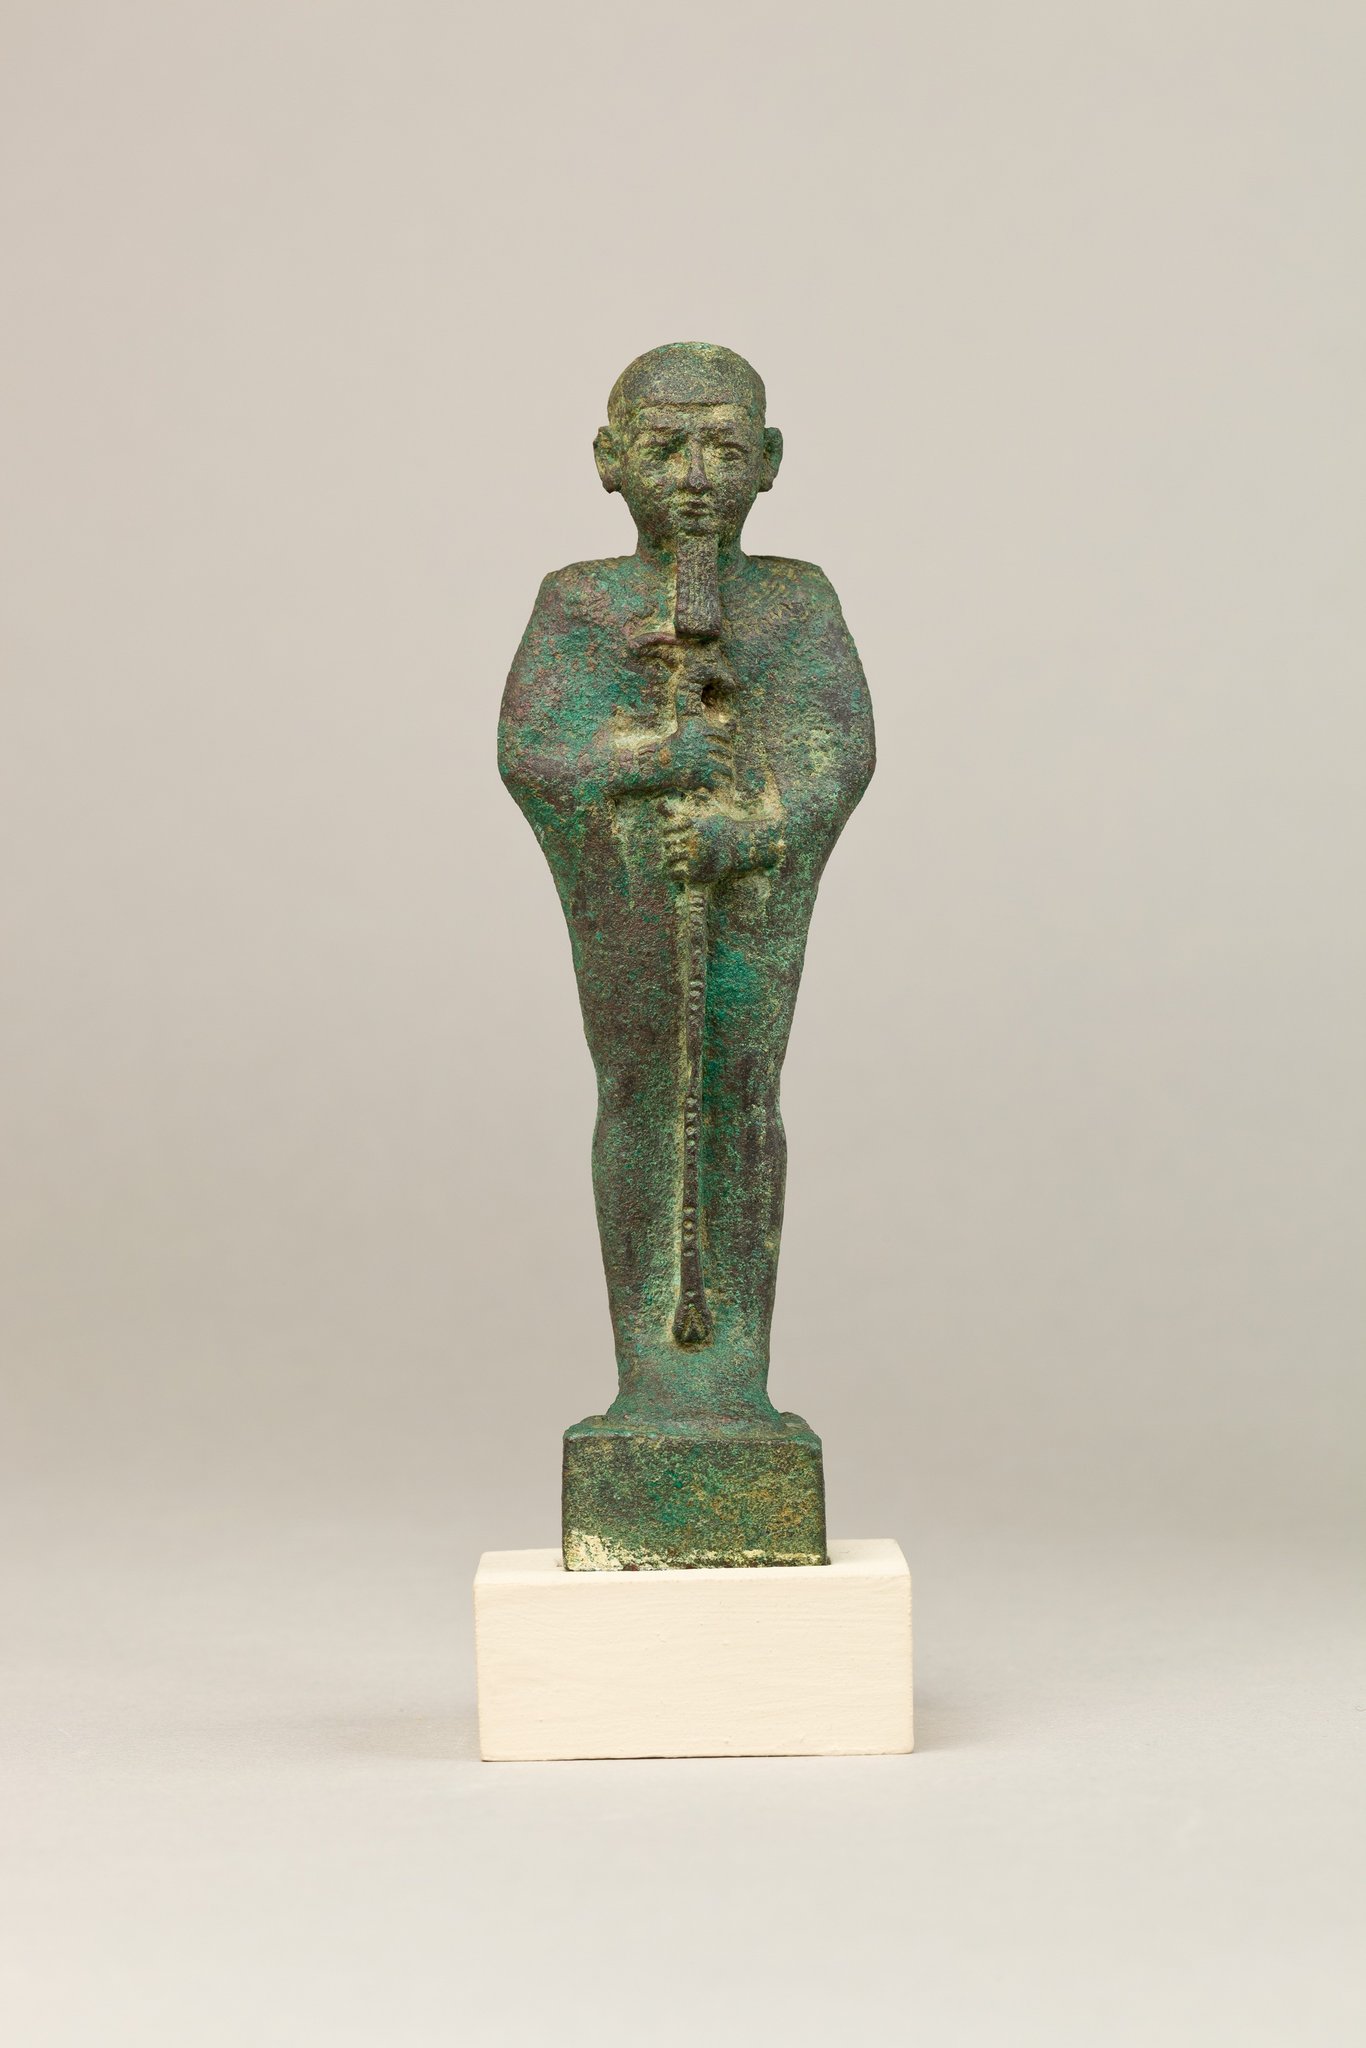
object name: statuette, ptah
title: Ptah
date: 664-630 BCE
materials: metal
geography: egypt